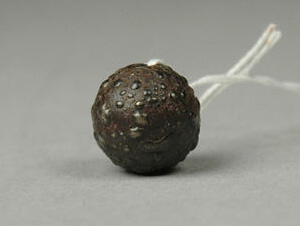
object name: ojime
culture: japanese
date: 1801-1900